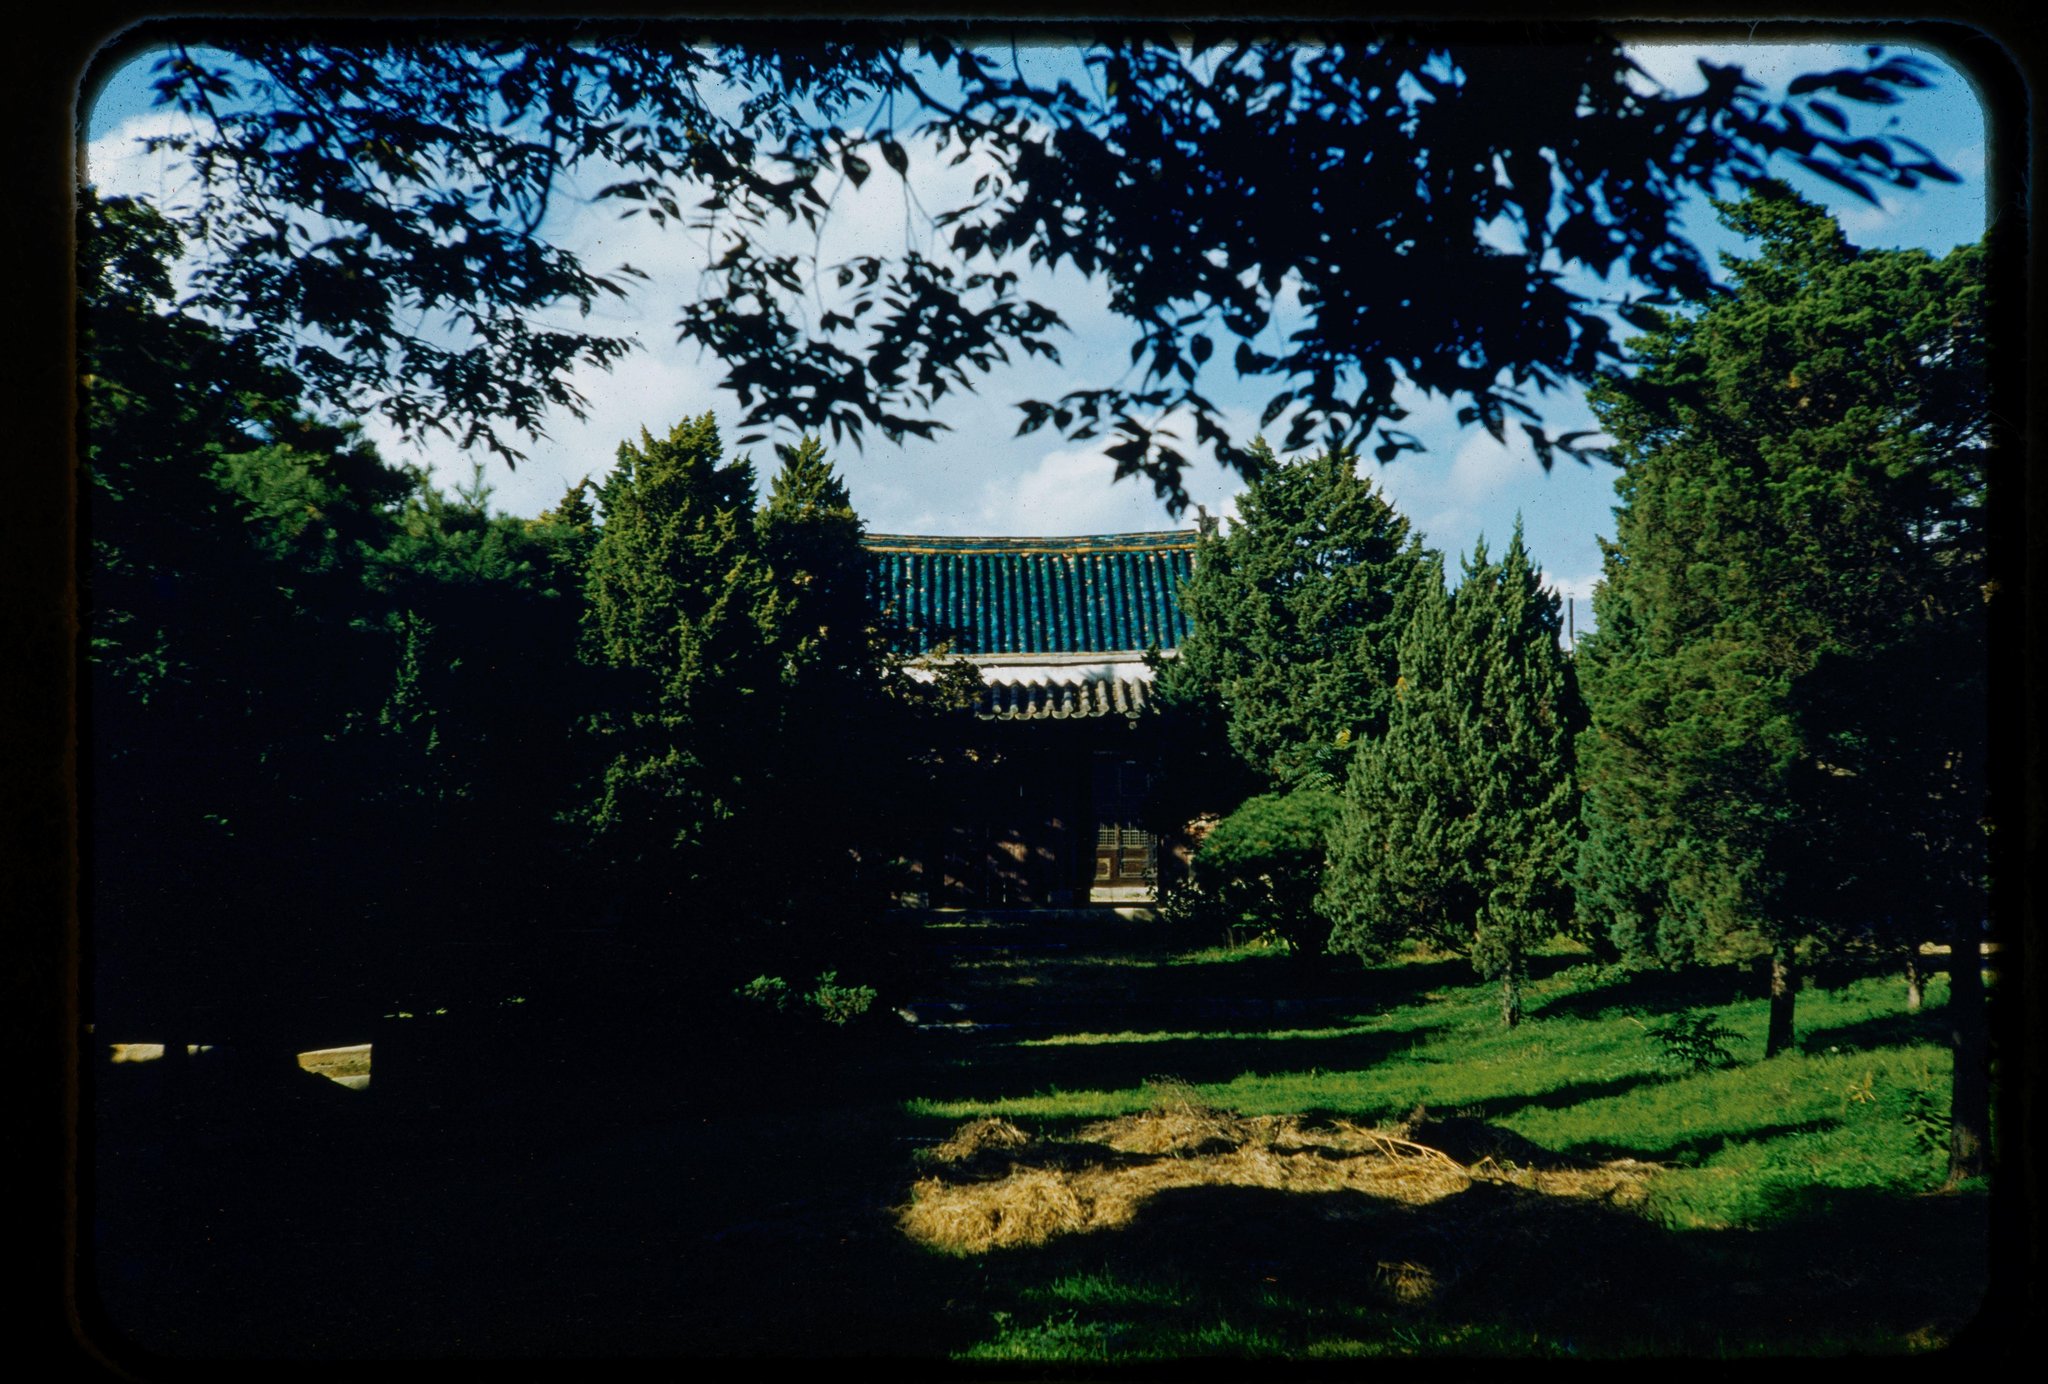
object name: color slide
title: Het oude keizerlijke paleis in Seoul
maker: david ketel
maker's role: diplomaat, sinoloog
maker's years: 1913-2008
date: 1952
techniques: slide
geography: seoul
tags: united nations